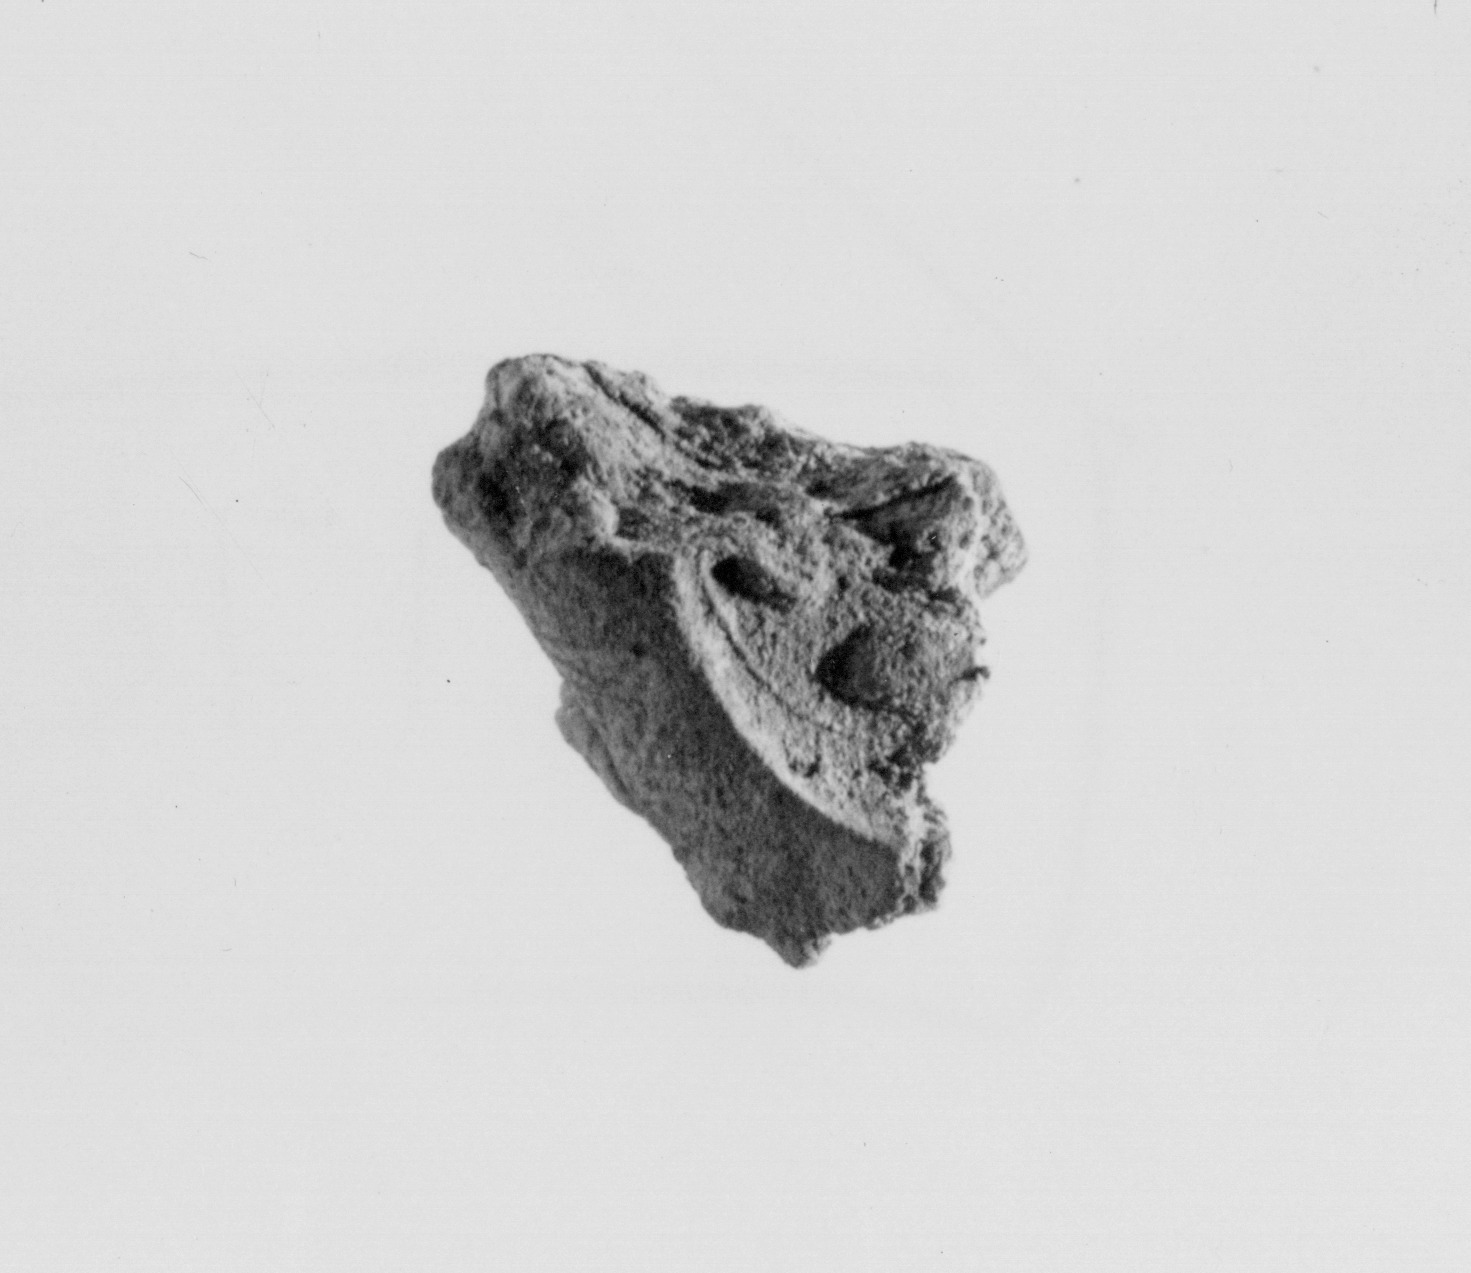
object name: sealing, ptah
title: Document Sealing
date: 1390-1352 BCE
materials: mud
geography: egypt